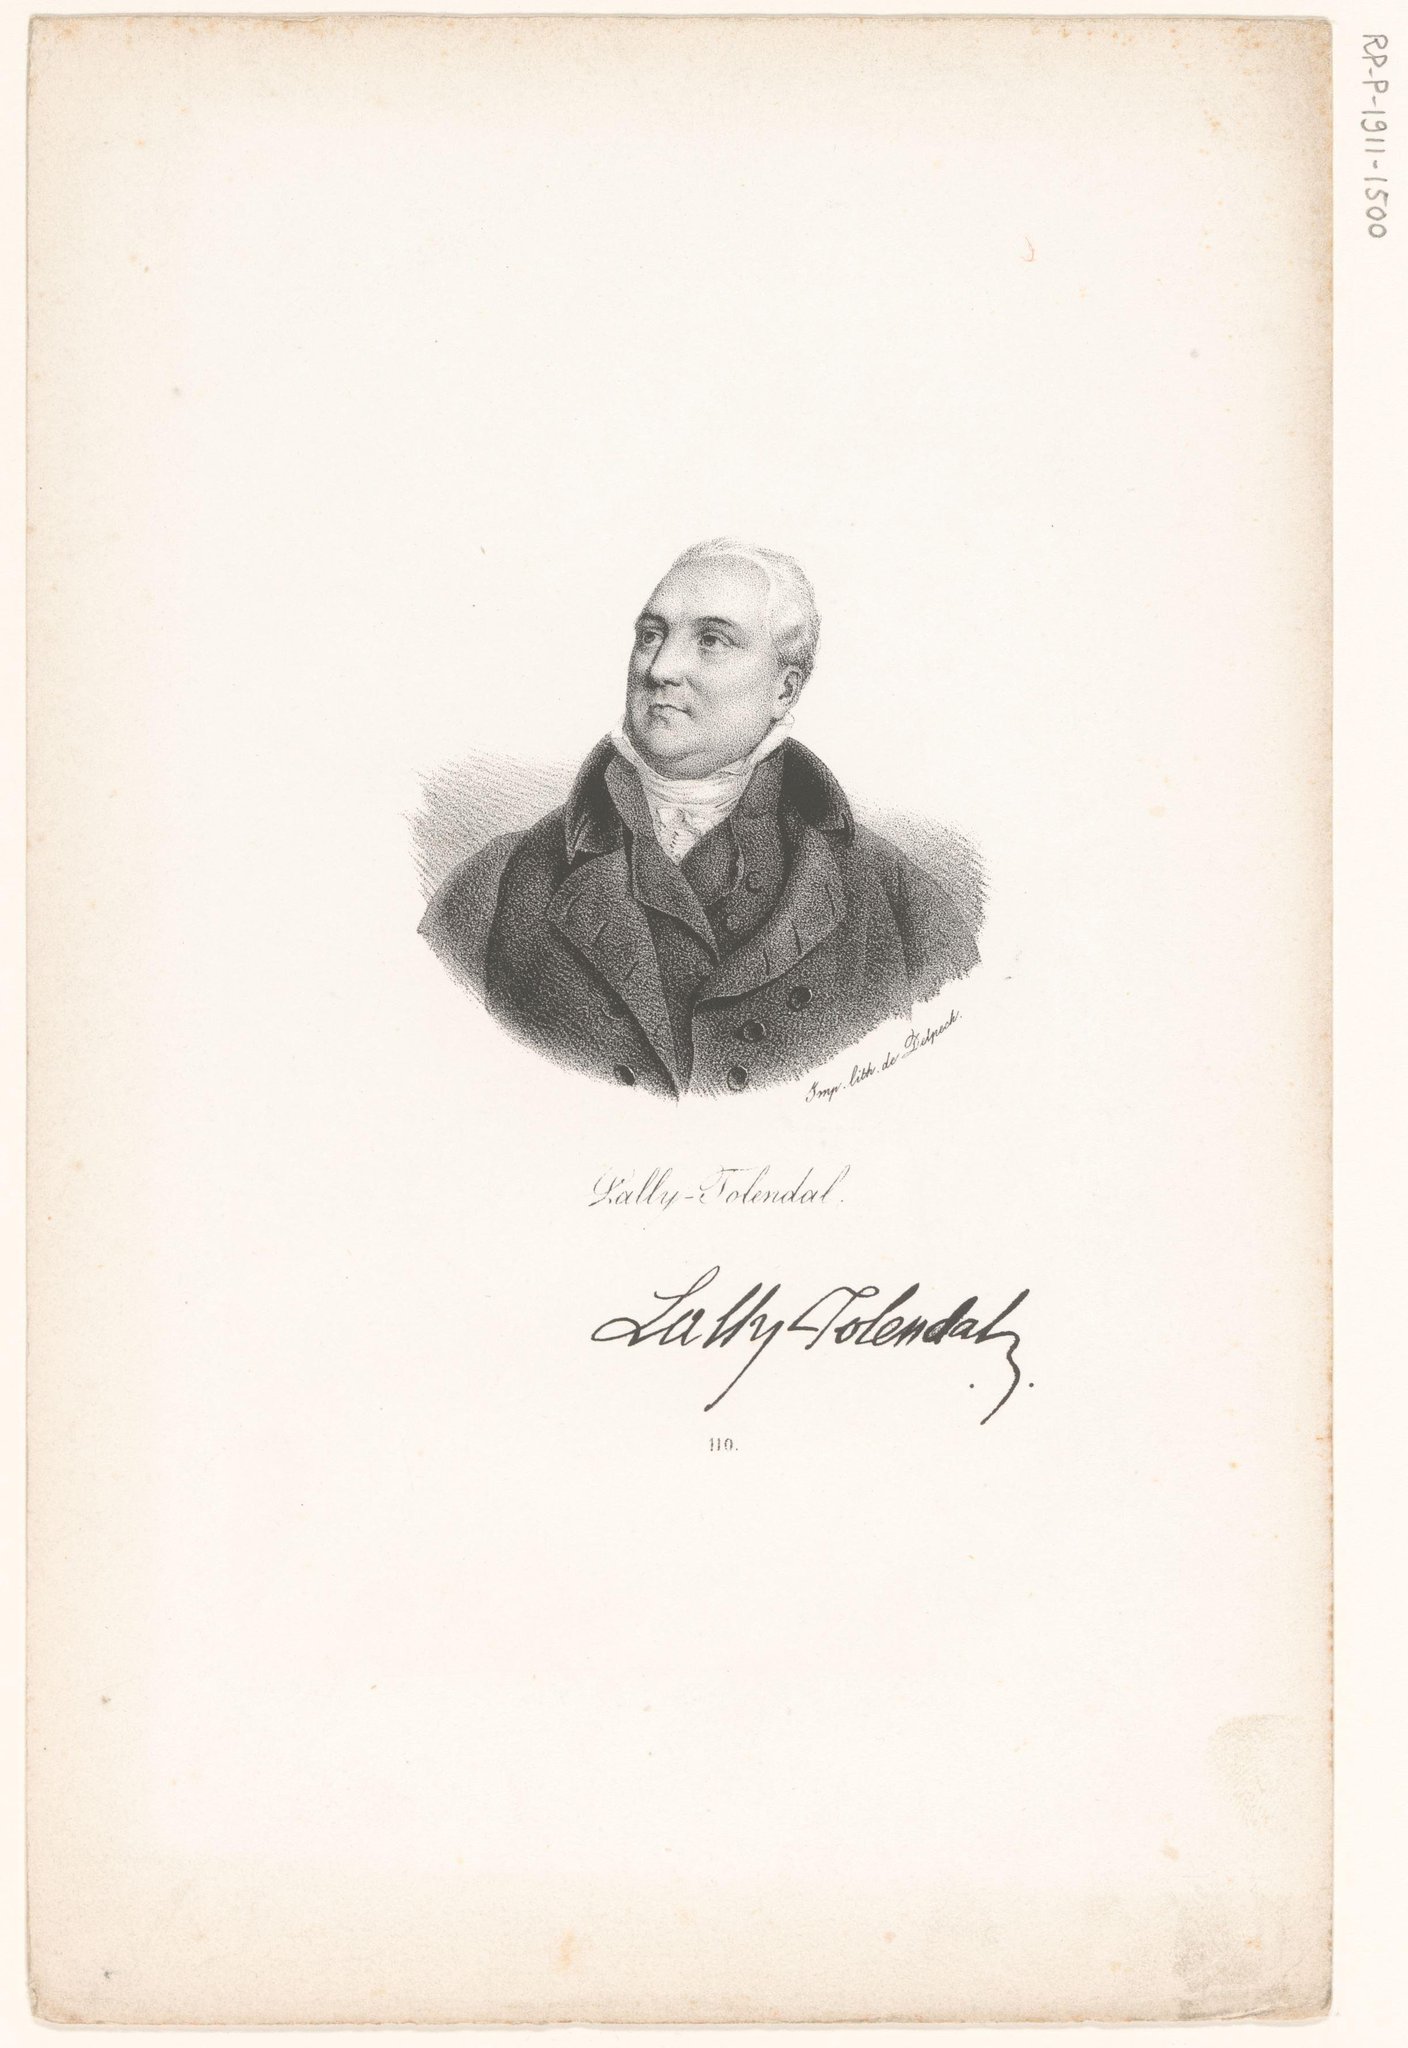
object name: print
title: Portret van Trophime Gerard Lally-Tollendal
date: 1818-1842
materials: paper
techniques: lithograph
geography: paris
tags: paris, politician, gérard de lally-tollendal, historical persons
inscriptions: collector's mark: Lugt 2228a